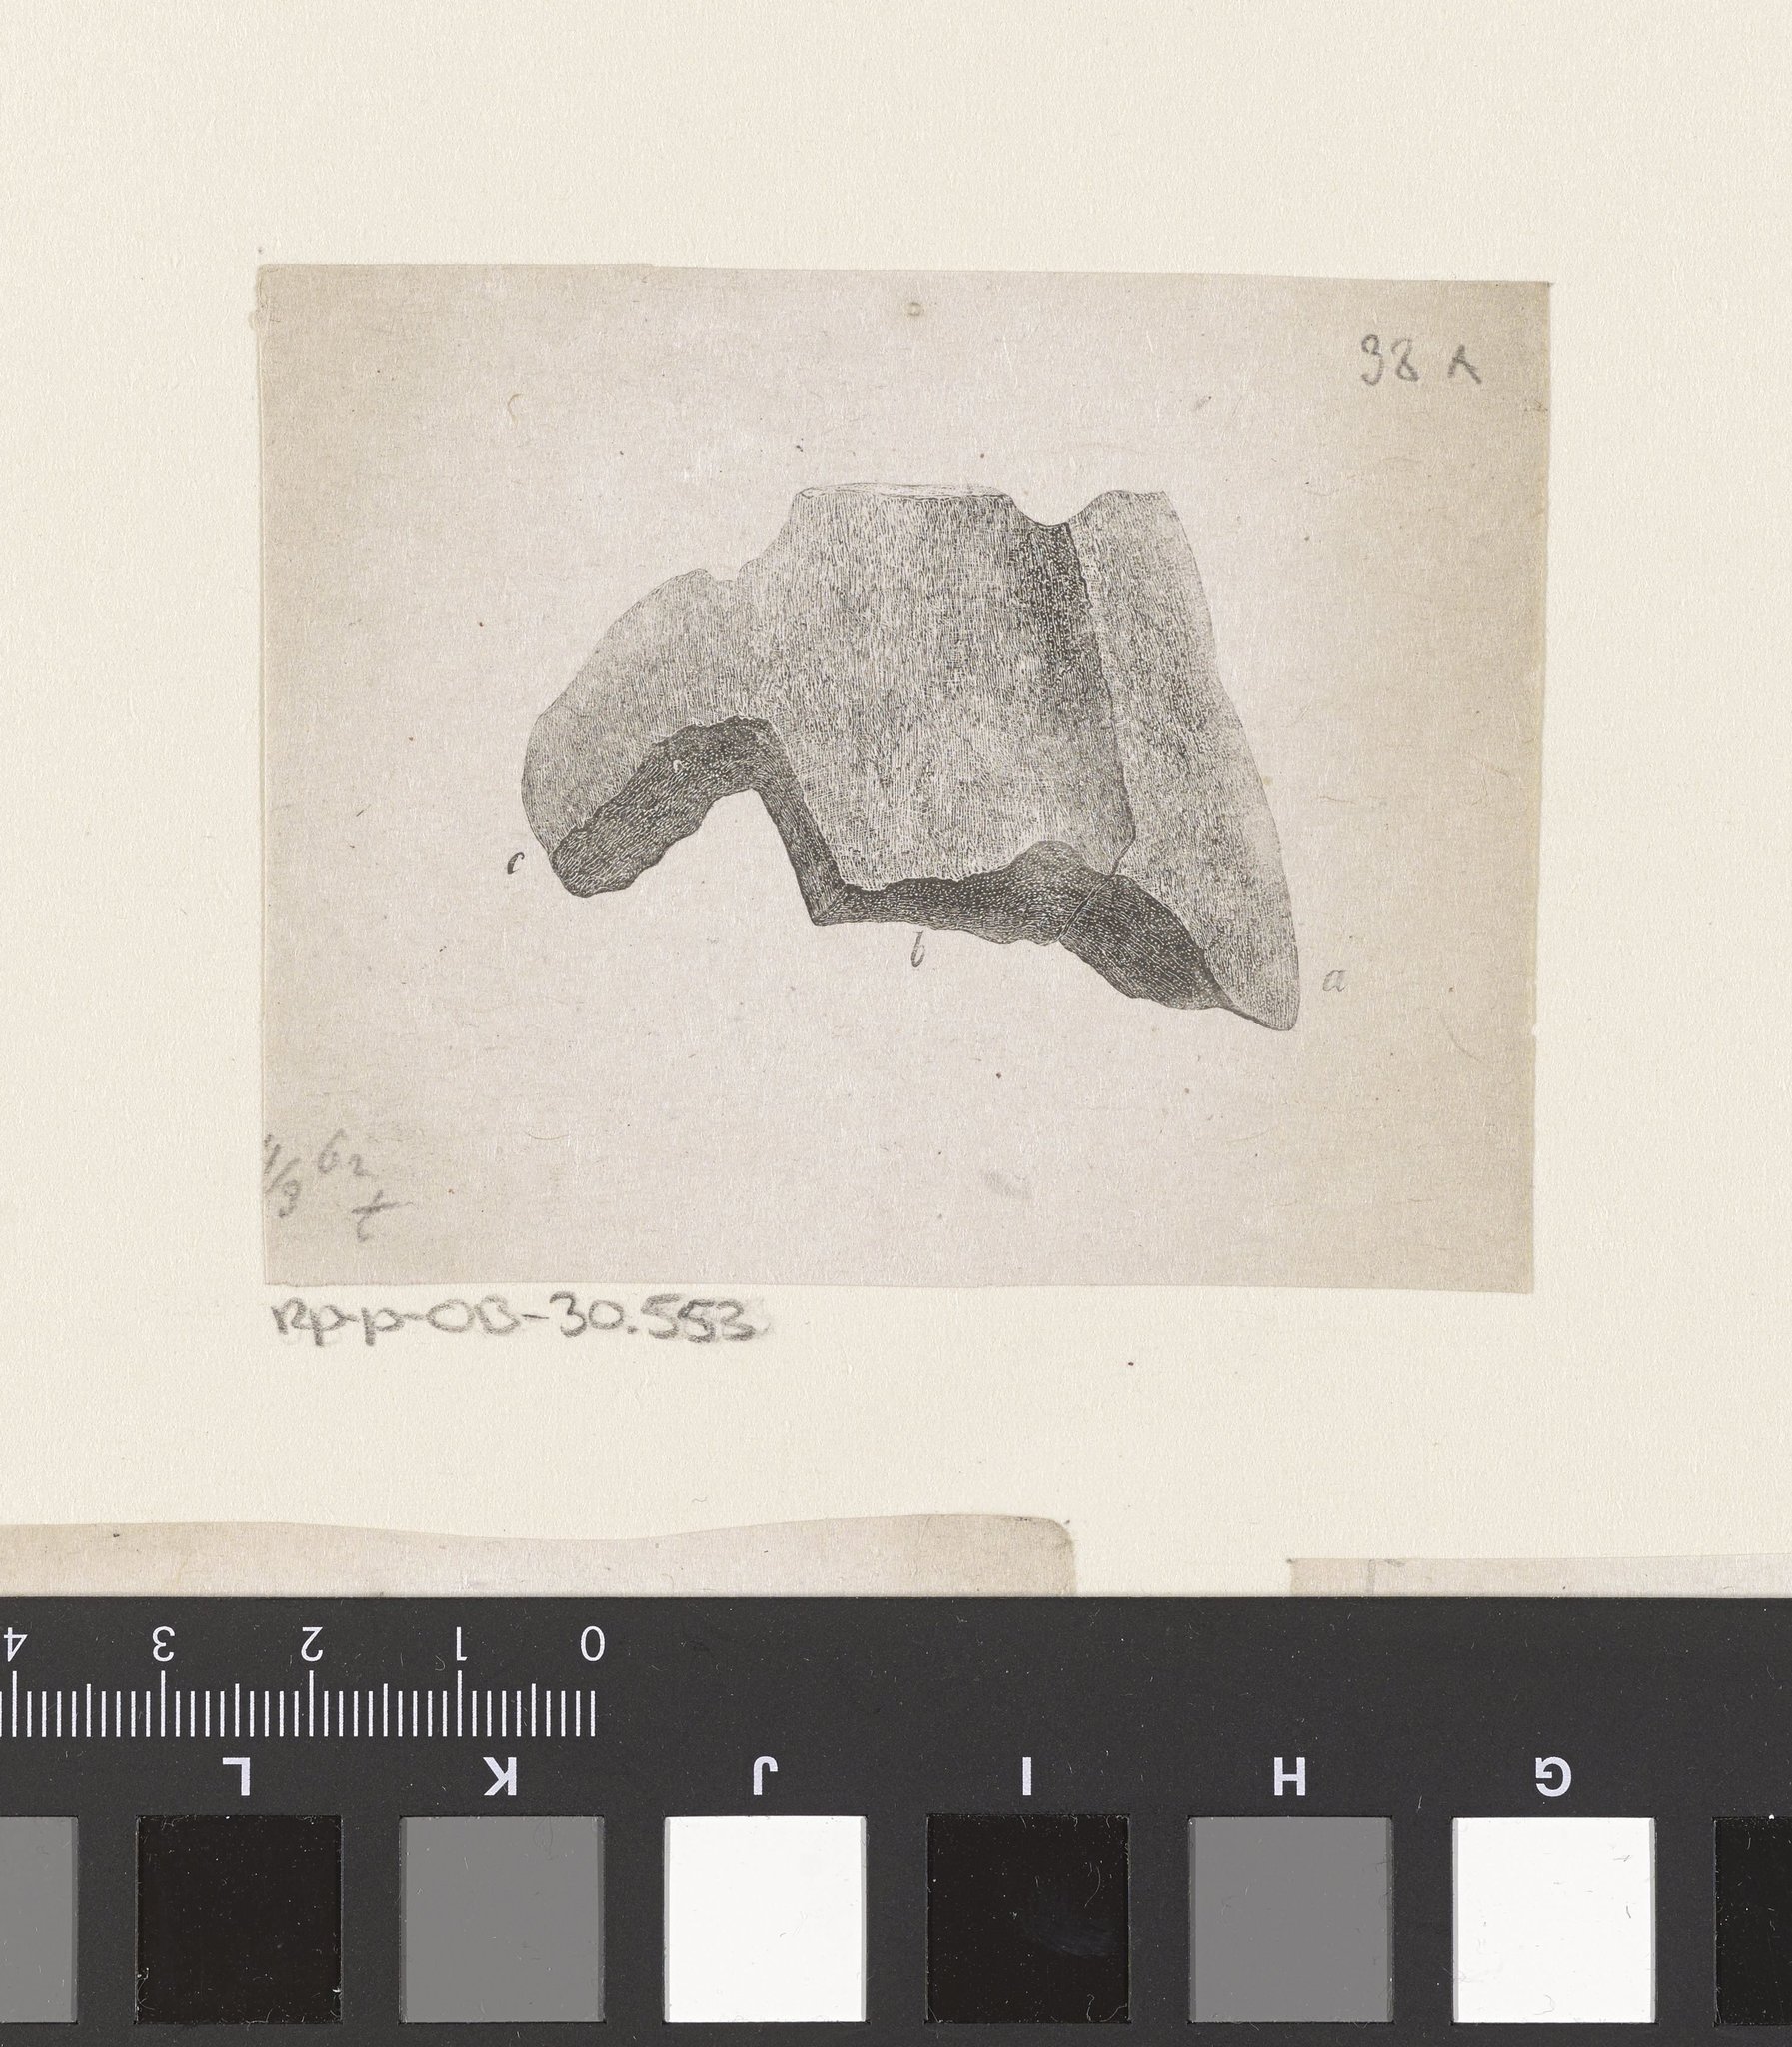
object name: print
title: Onderdeel van het menselijk lichaam met een afwijking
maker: isaac weissenbruch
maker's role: print maker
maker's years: 1826-1912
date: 1836-1912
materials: paper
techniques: engraving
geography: netherlands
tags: anatomy (non-medical), diseases